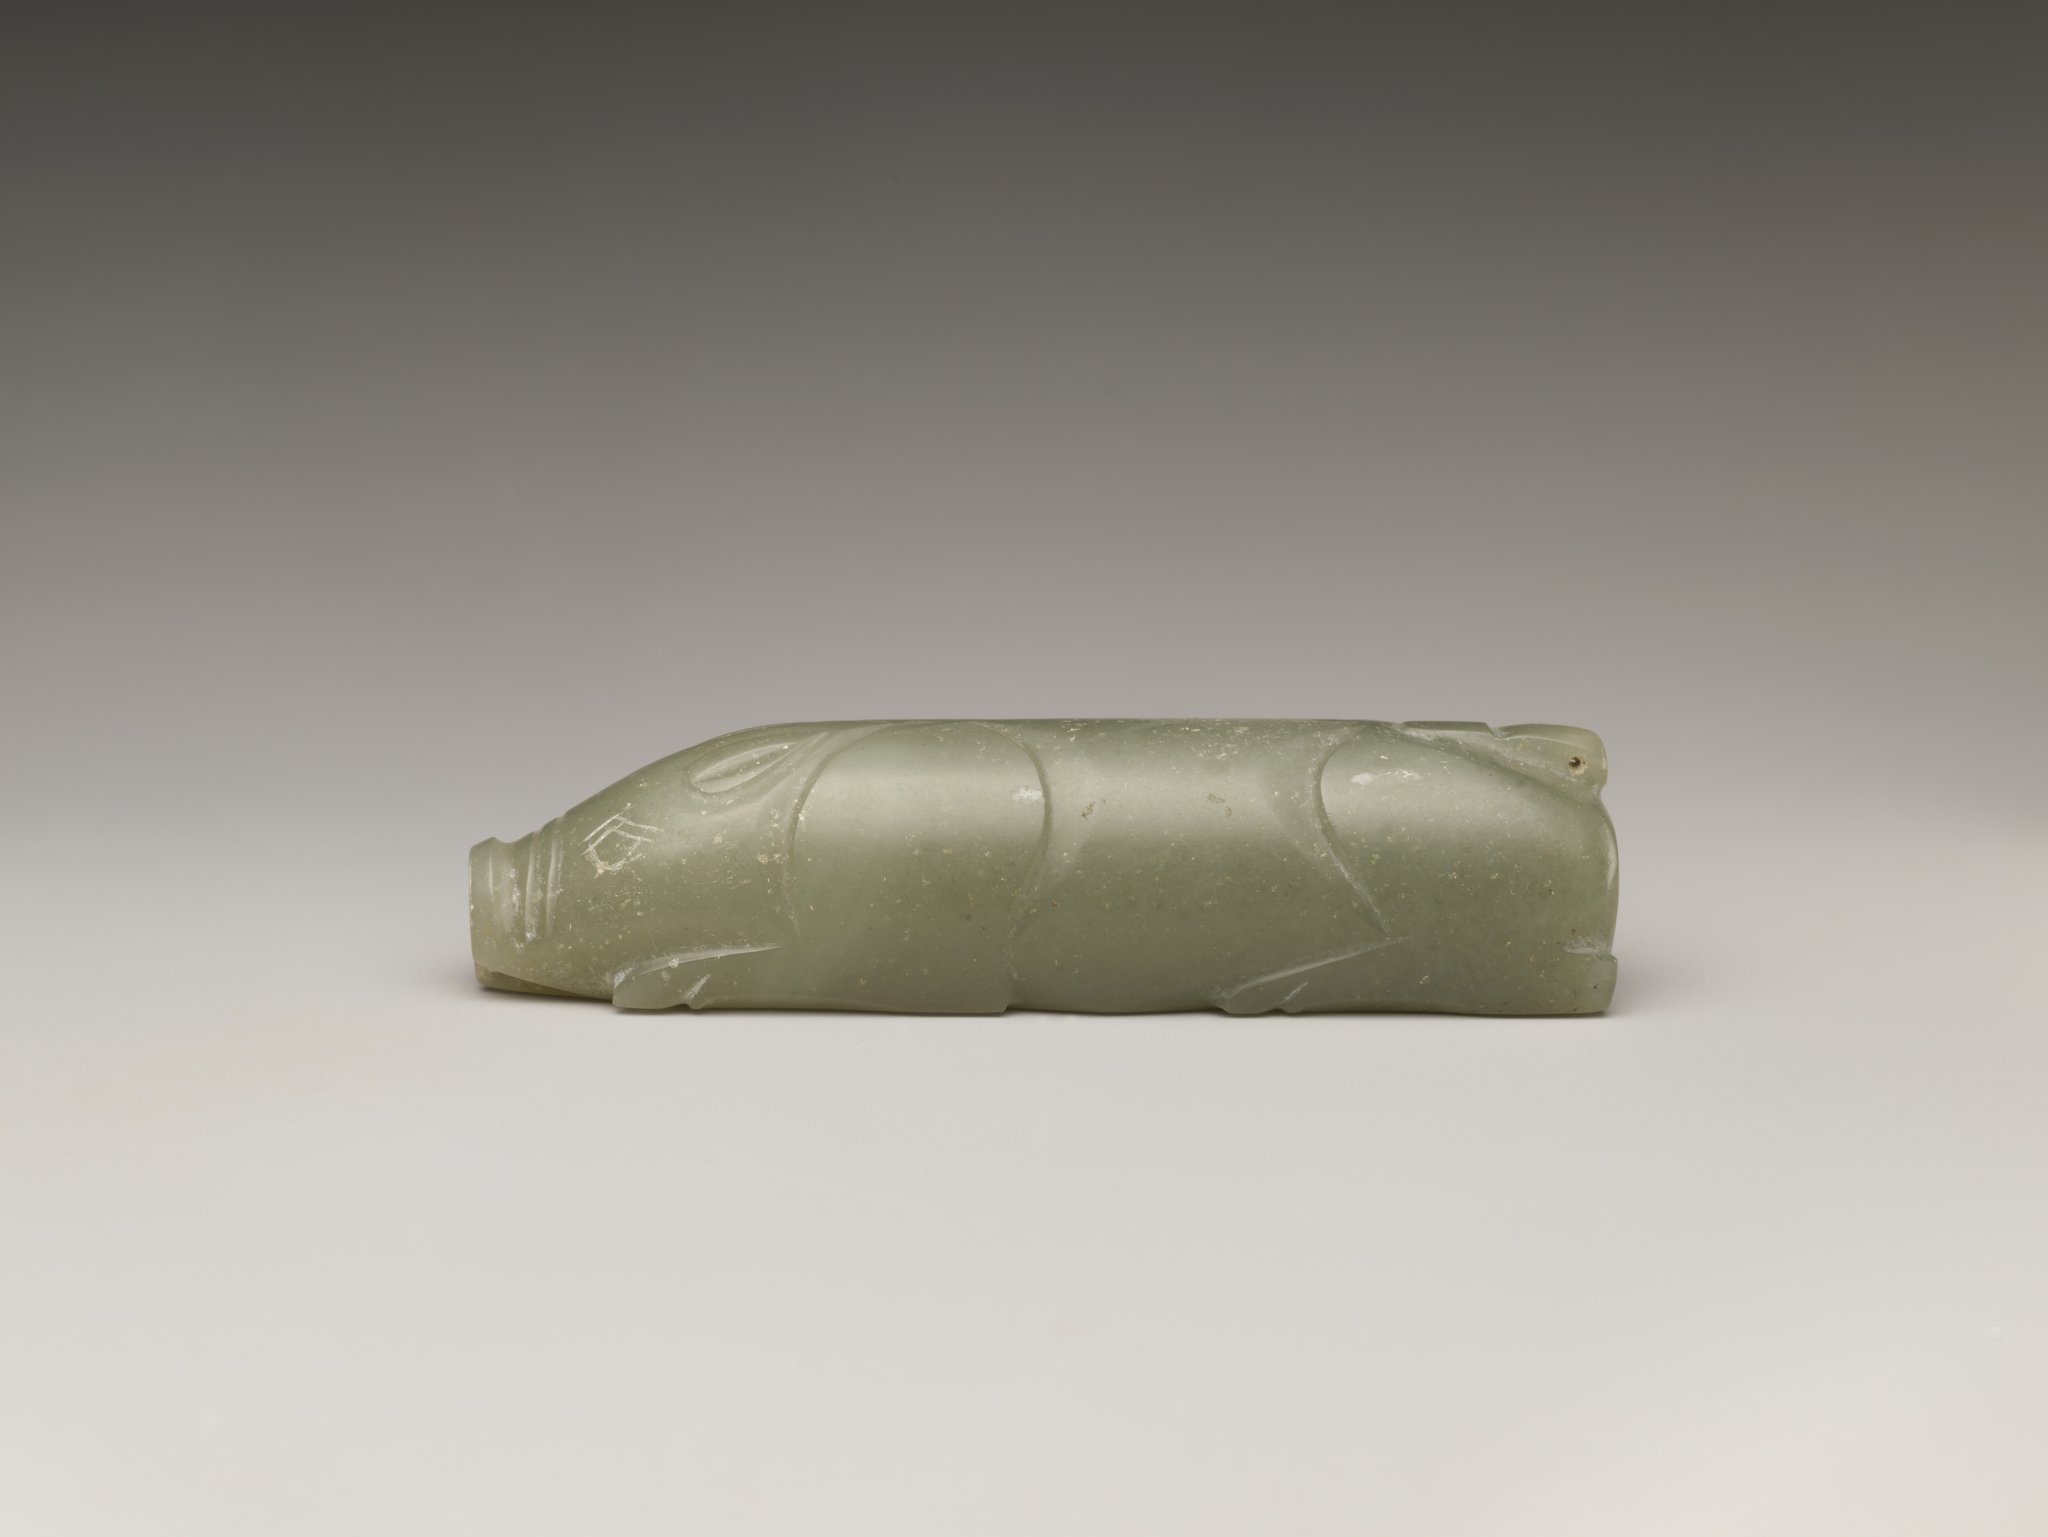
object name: figure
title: Pig in Recumbent Position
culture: chinese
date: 1-200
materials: jade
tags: pigs